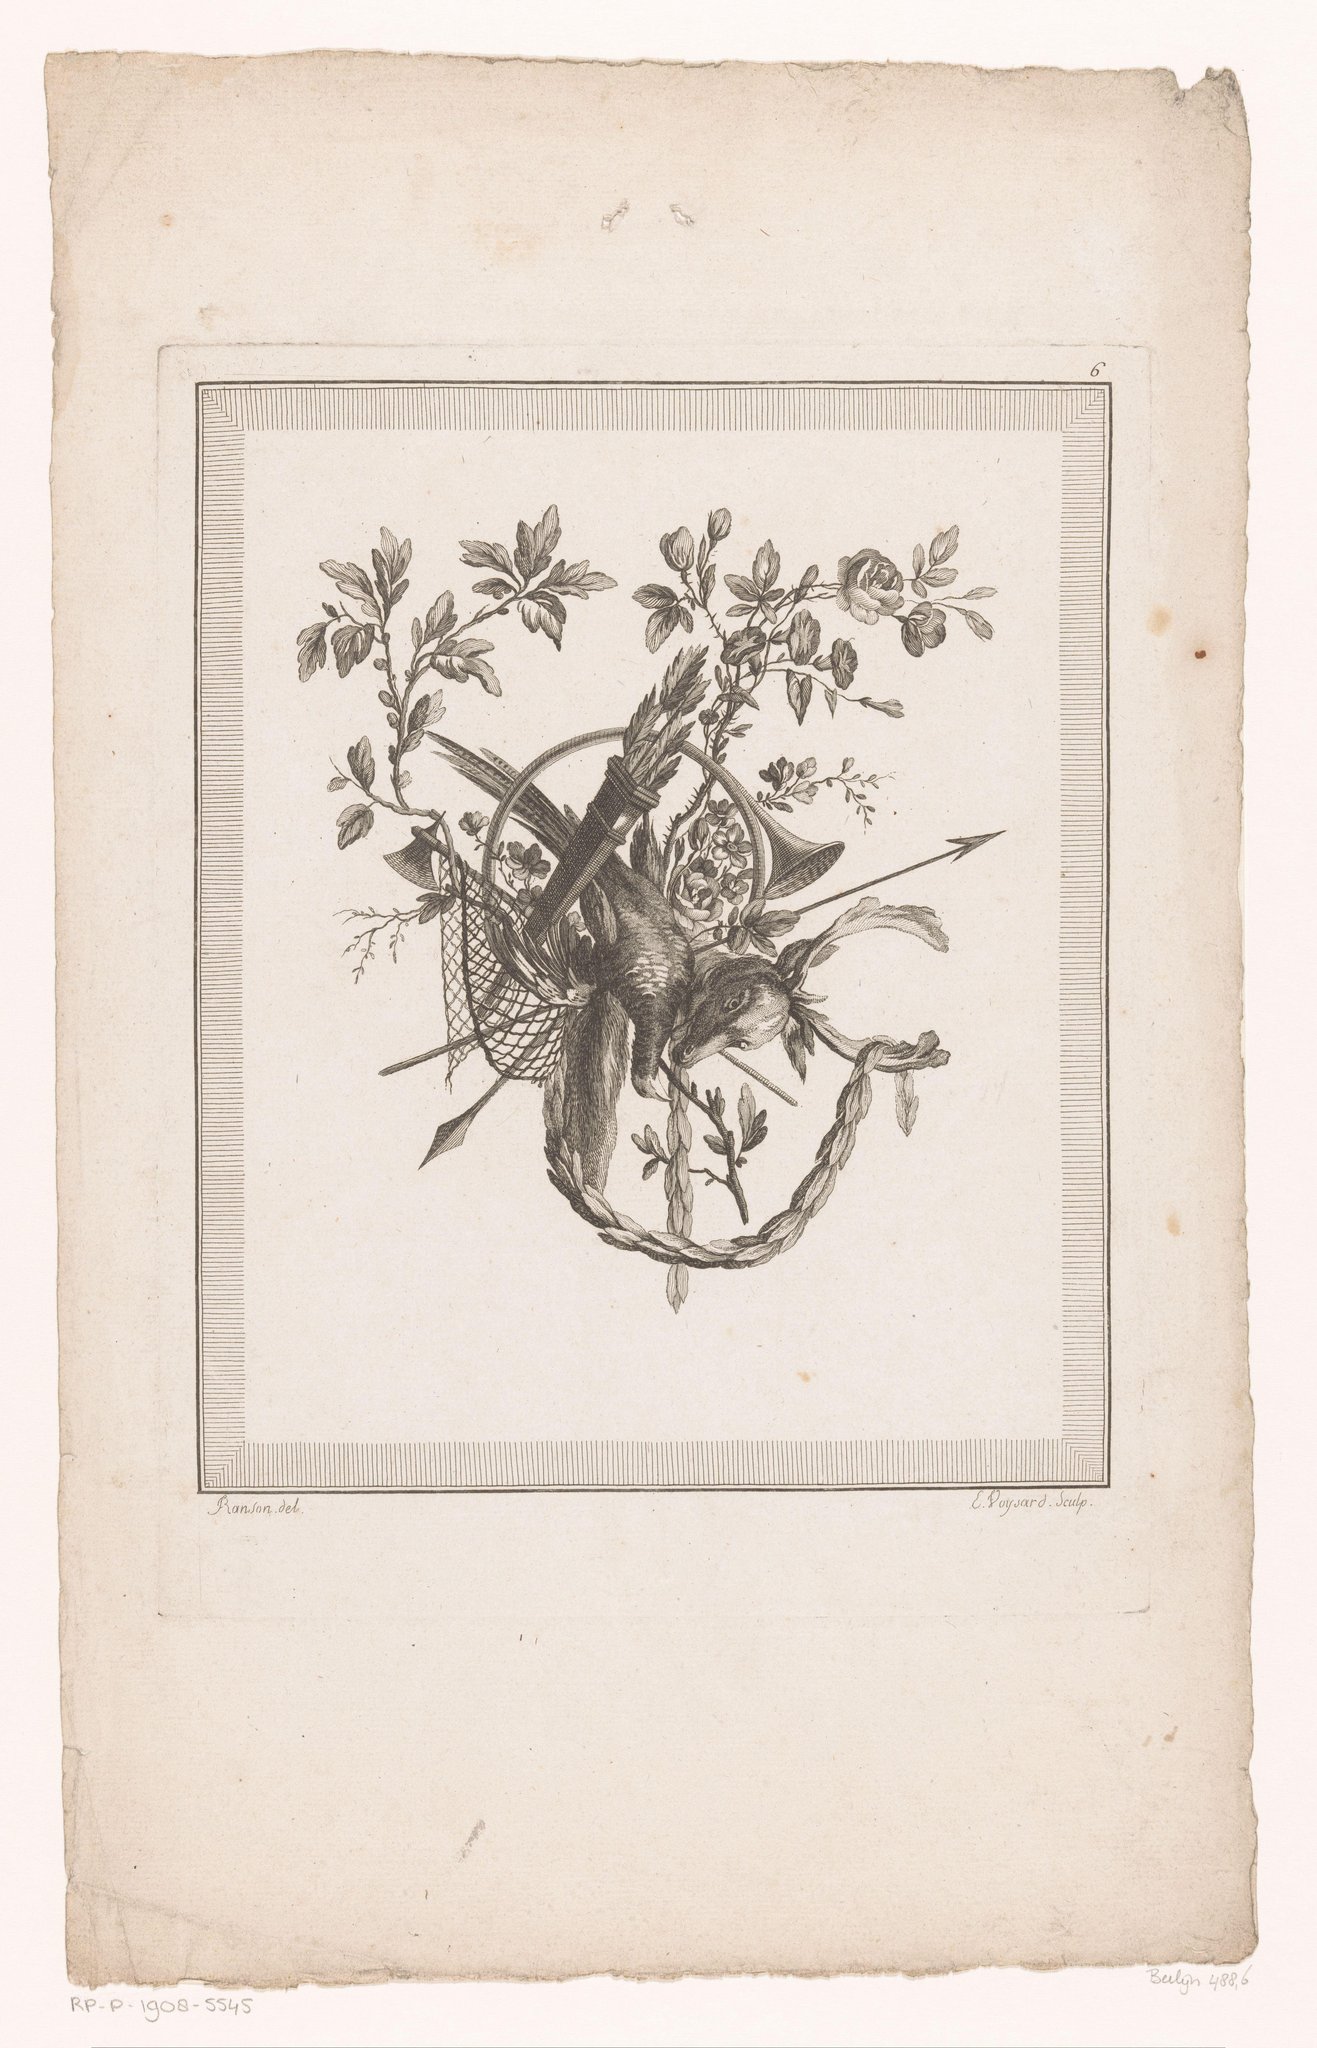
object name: print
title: Jachttrofee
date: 1778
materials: paper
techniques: etching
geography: paris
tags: hunting trophies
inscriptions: collector's mark: Lugt 2228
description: Een jachttrofee met een jachthoorn, een pijlenkoker, speren, een hellebaard, een hertenkop en een fazant.